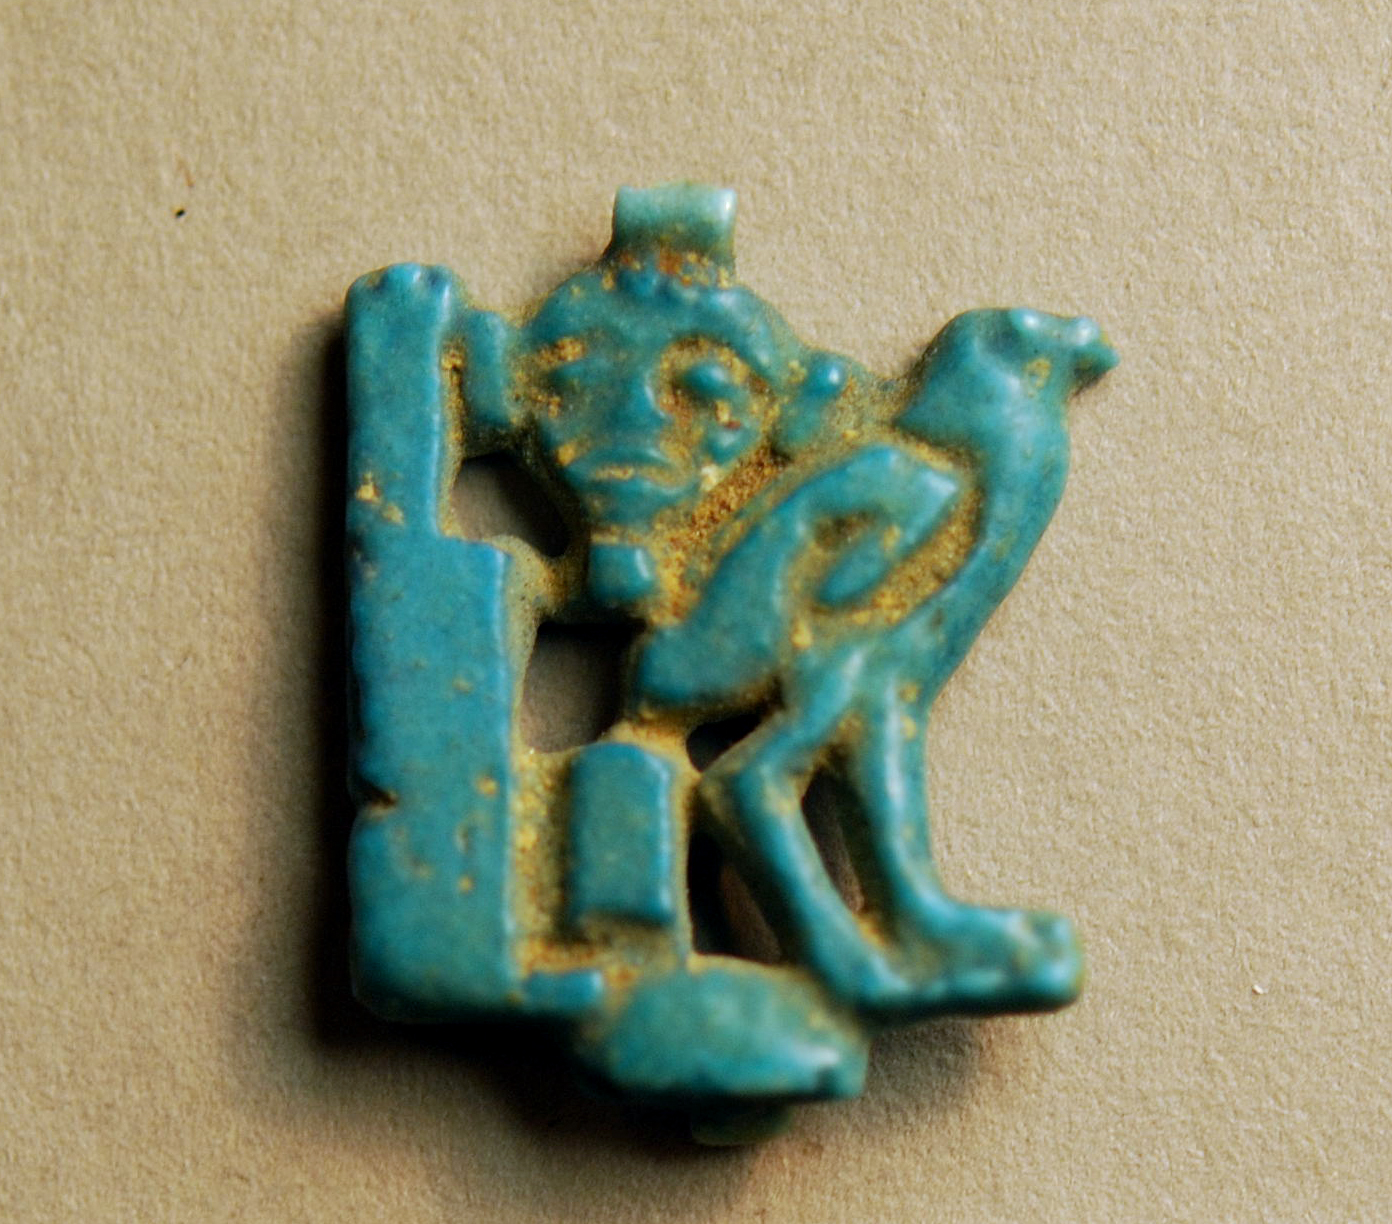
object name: amulet, hieroglyphic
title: Hieroglyphic Amulet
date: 1390-1352 BCE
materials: faience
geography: egypt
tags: hieroglyphs